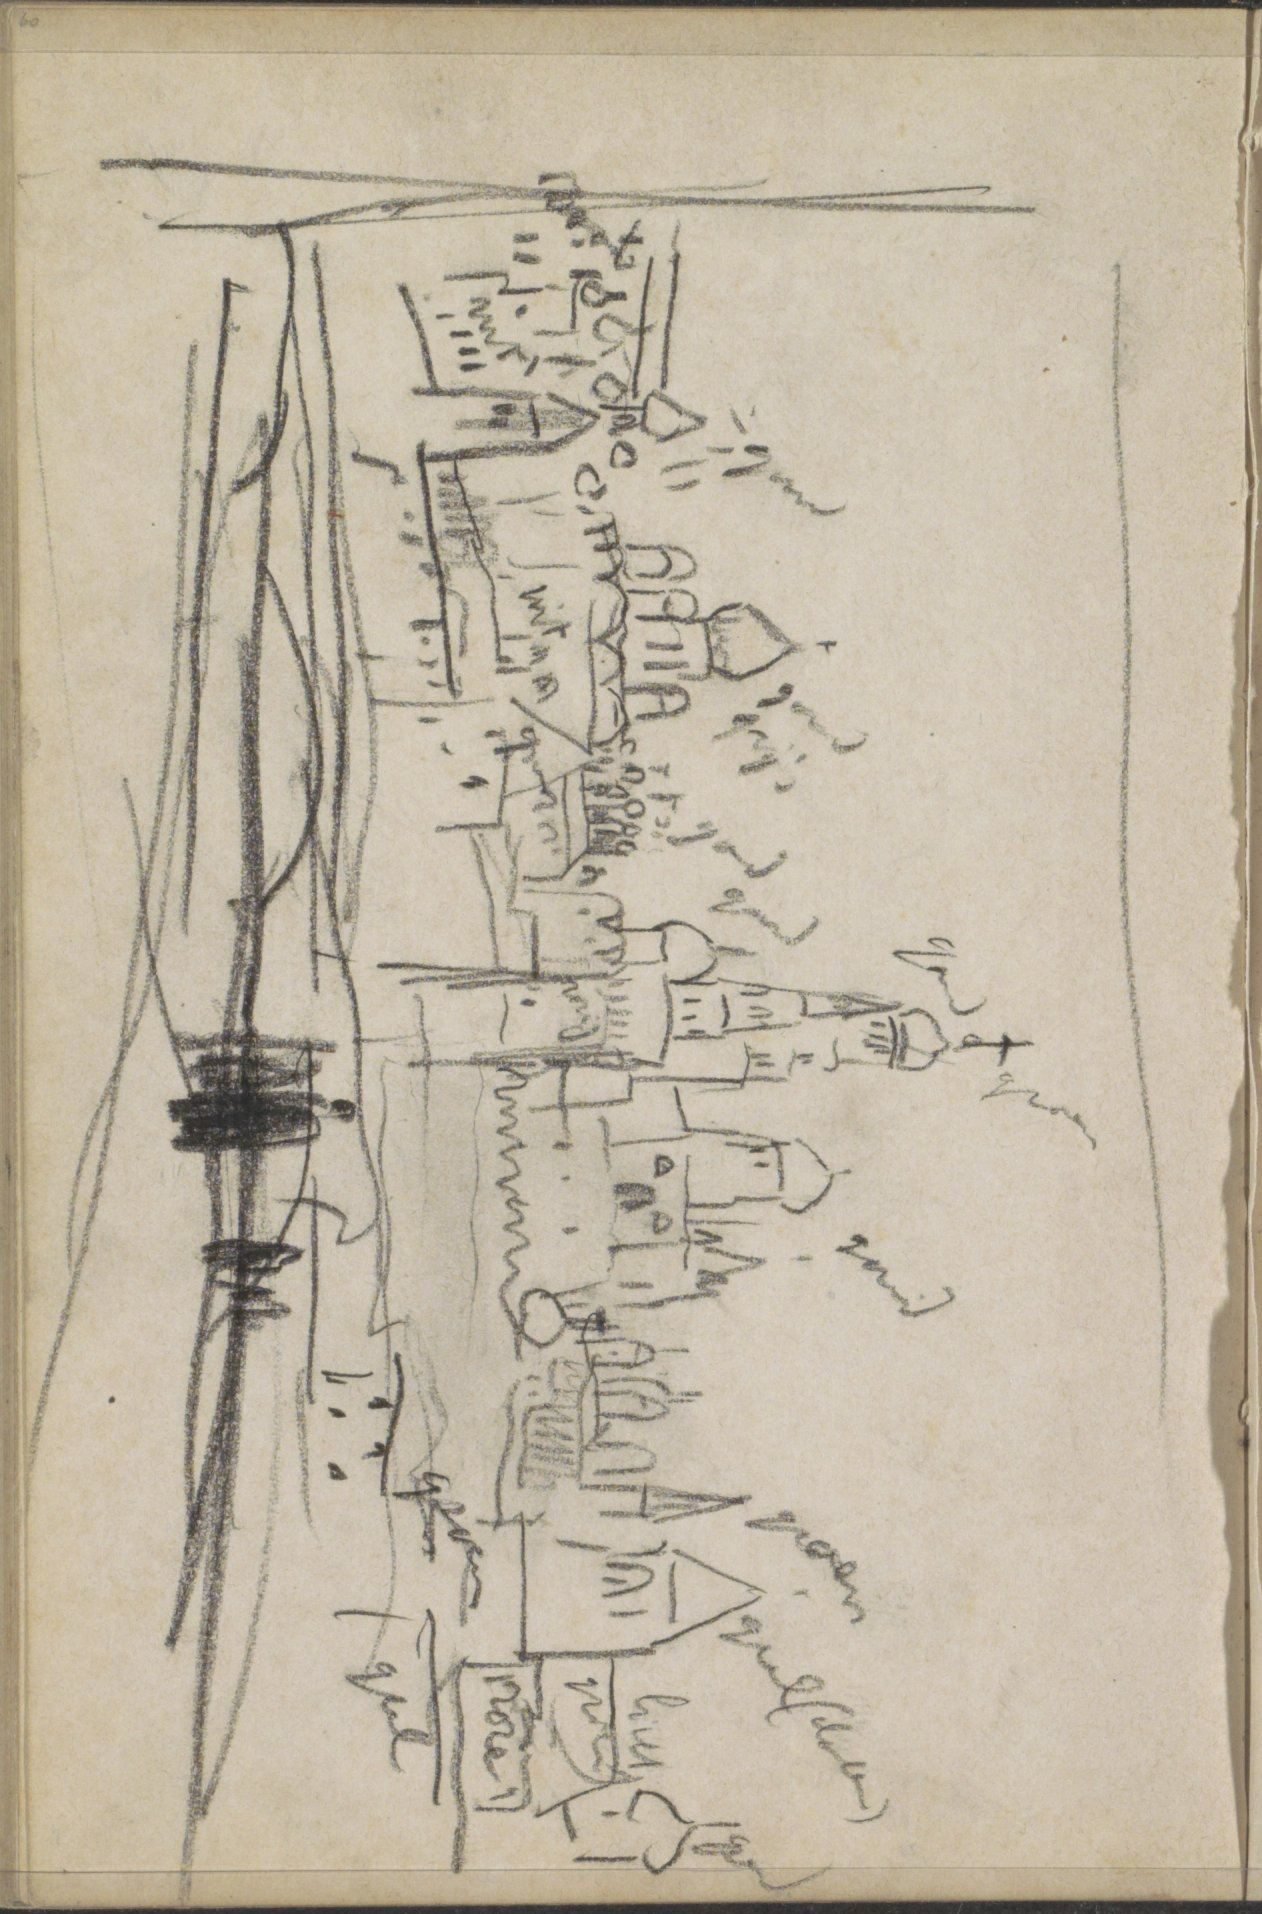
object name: sketchbook leaf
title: Gezicht op het Kremlin van Moskou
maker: marius bauer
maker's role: draughtsman, print maker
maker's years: 1867-1932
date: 1896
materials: chalk, paper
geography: moscow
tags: city-view, and landscape with man-made constructions, russian orthodox church, dome ~ architecture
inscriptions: kleurnotitie, handgeschreven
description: Bauer bewerkte de schets voor een verslag van zijn reis naar Rusland voor het tijdschrift De Kroniek in 1896 (zie documentatie).